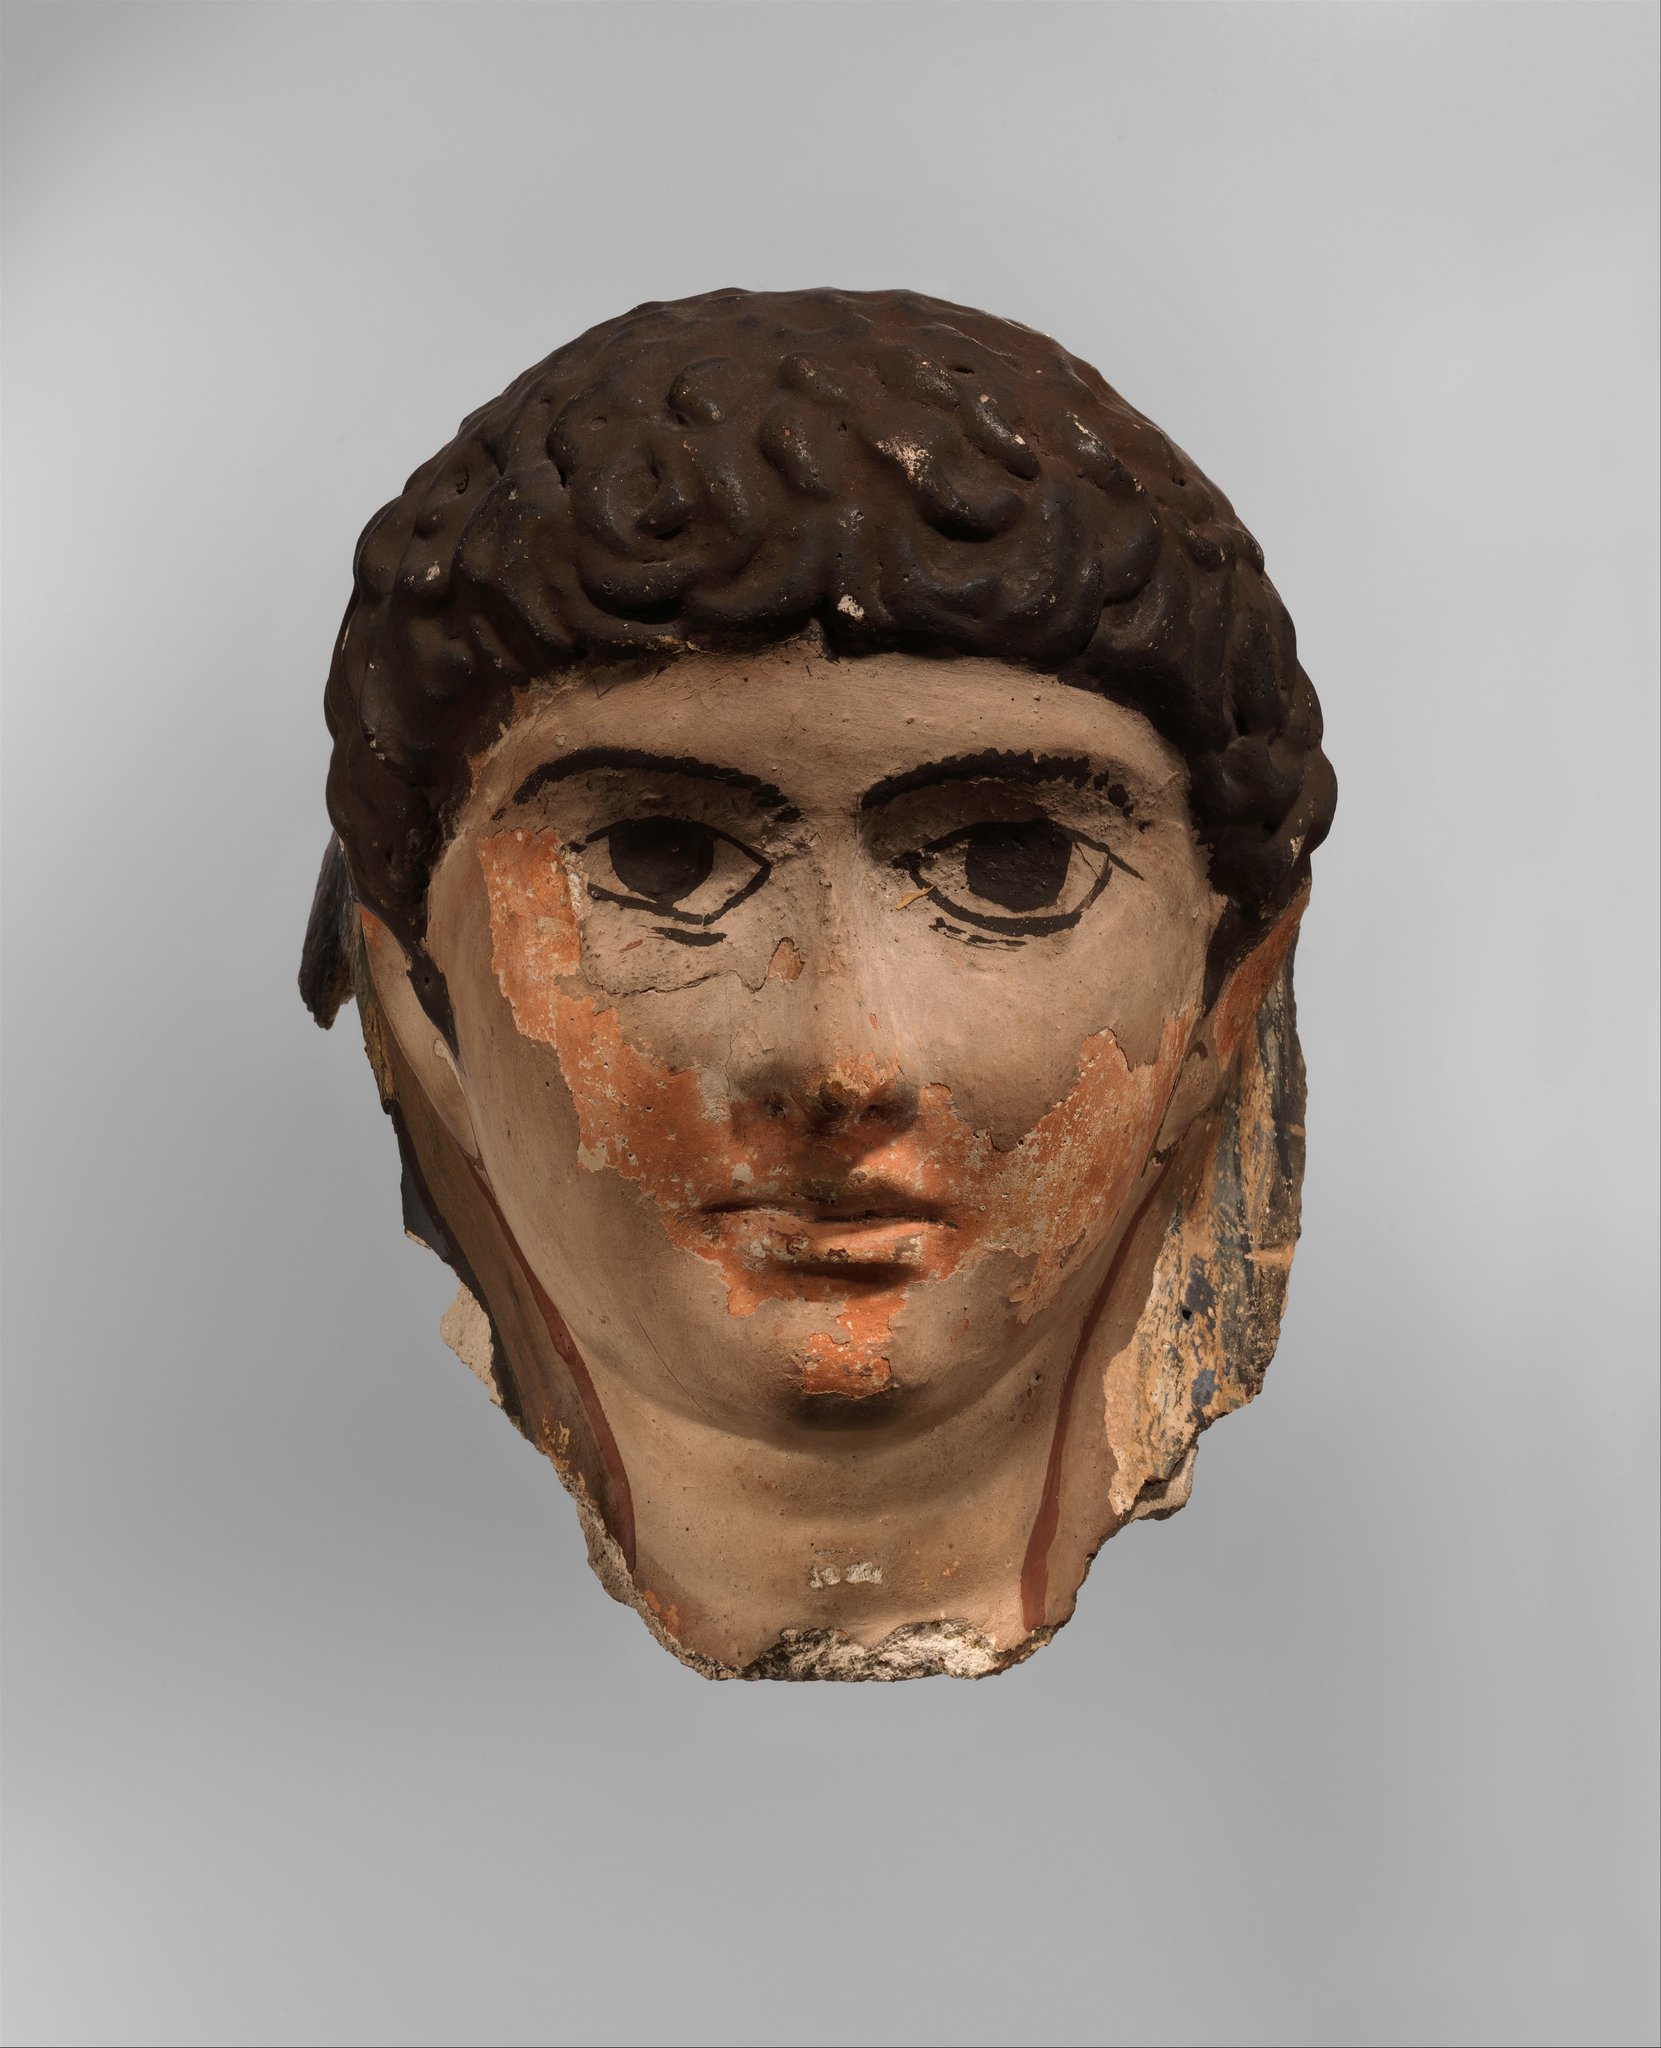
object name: mask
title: Funerary Mask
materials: paint, plaster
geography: egypt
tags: masks